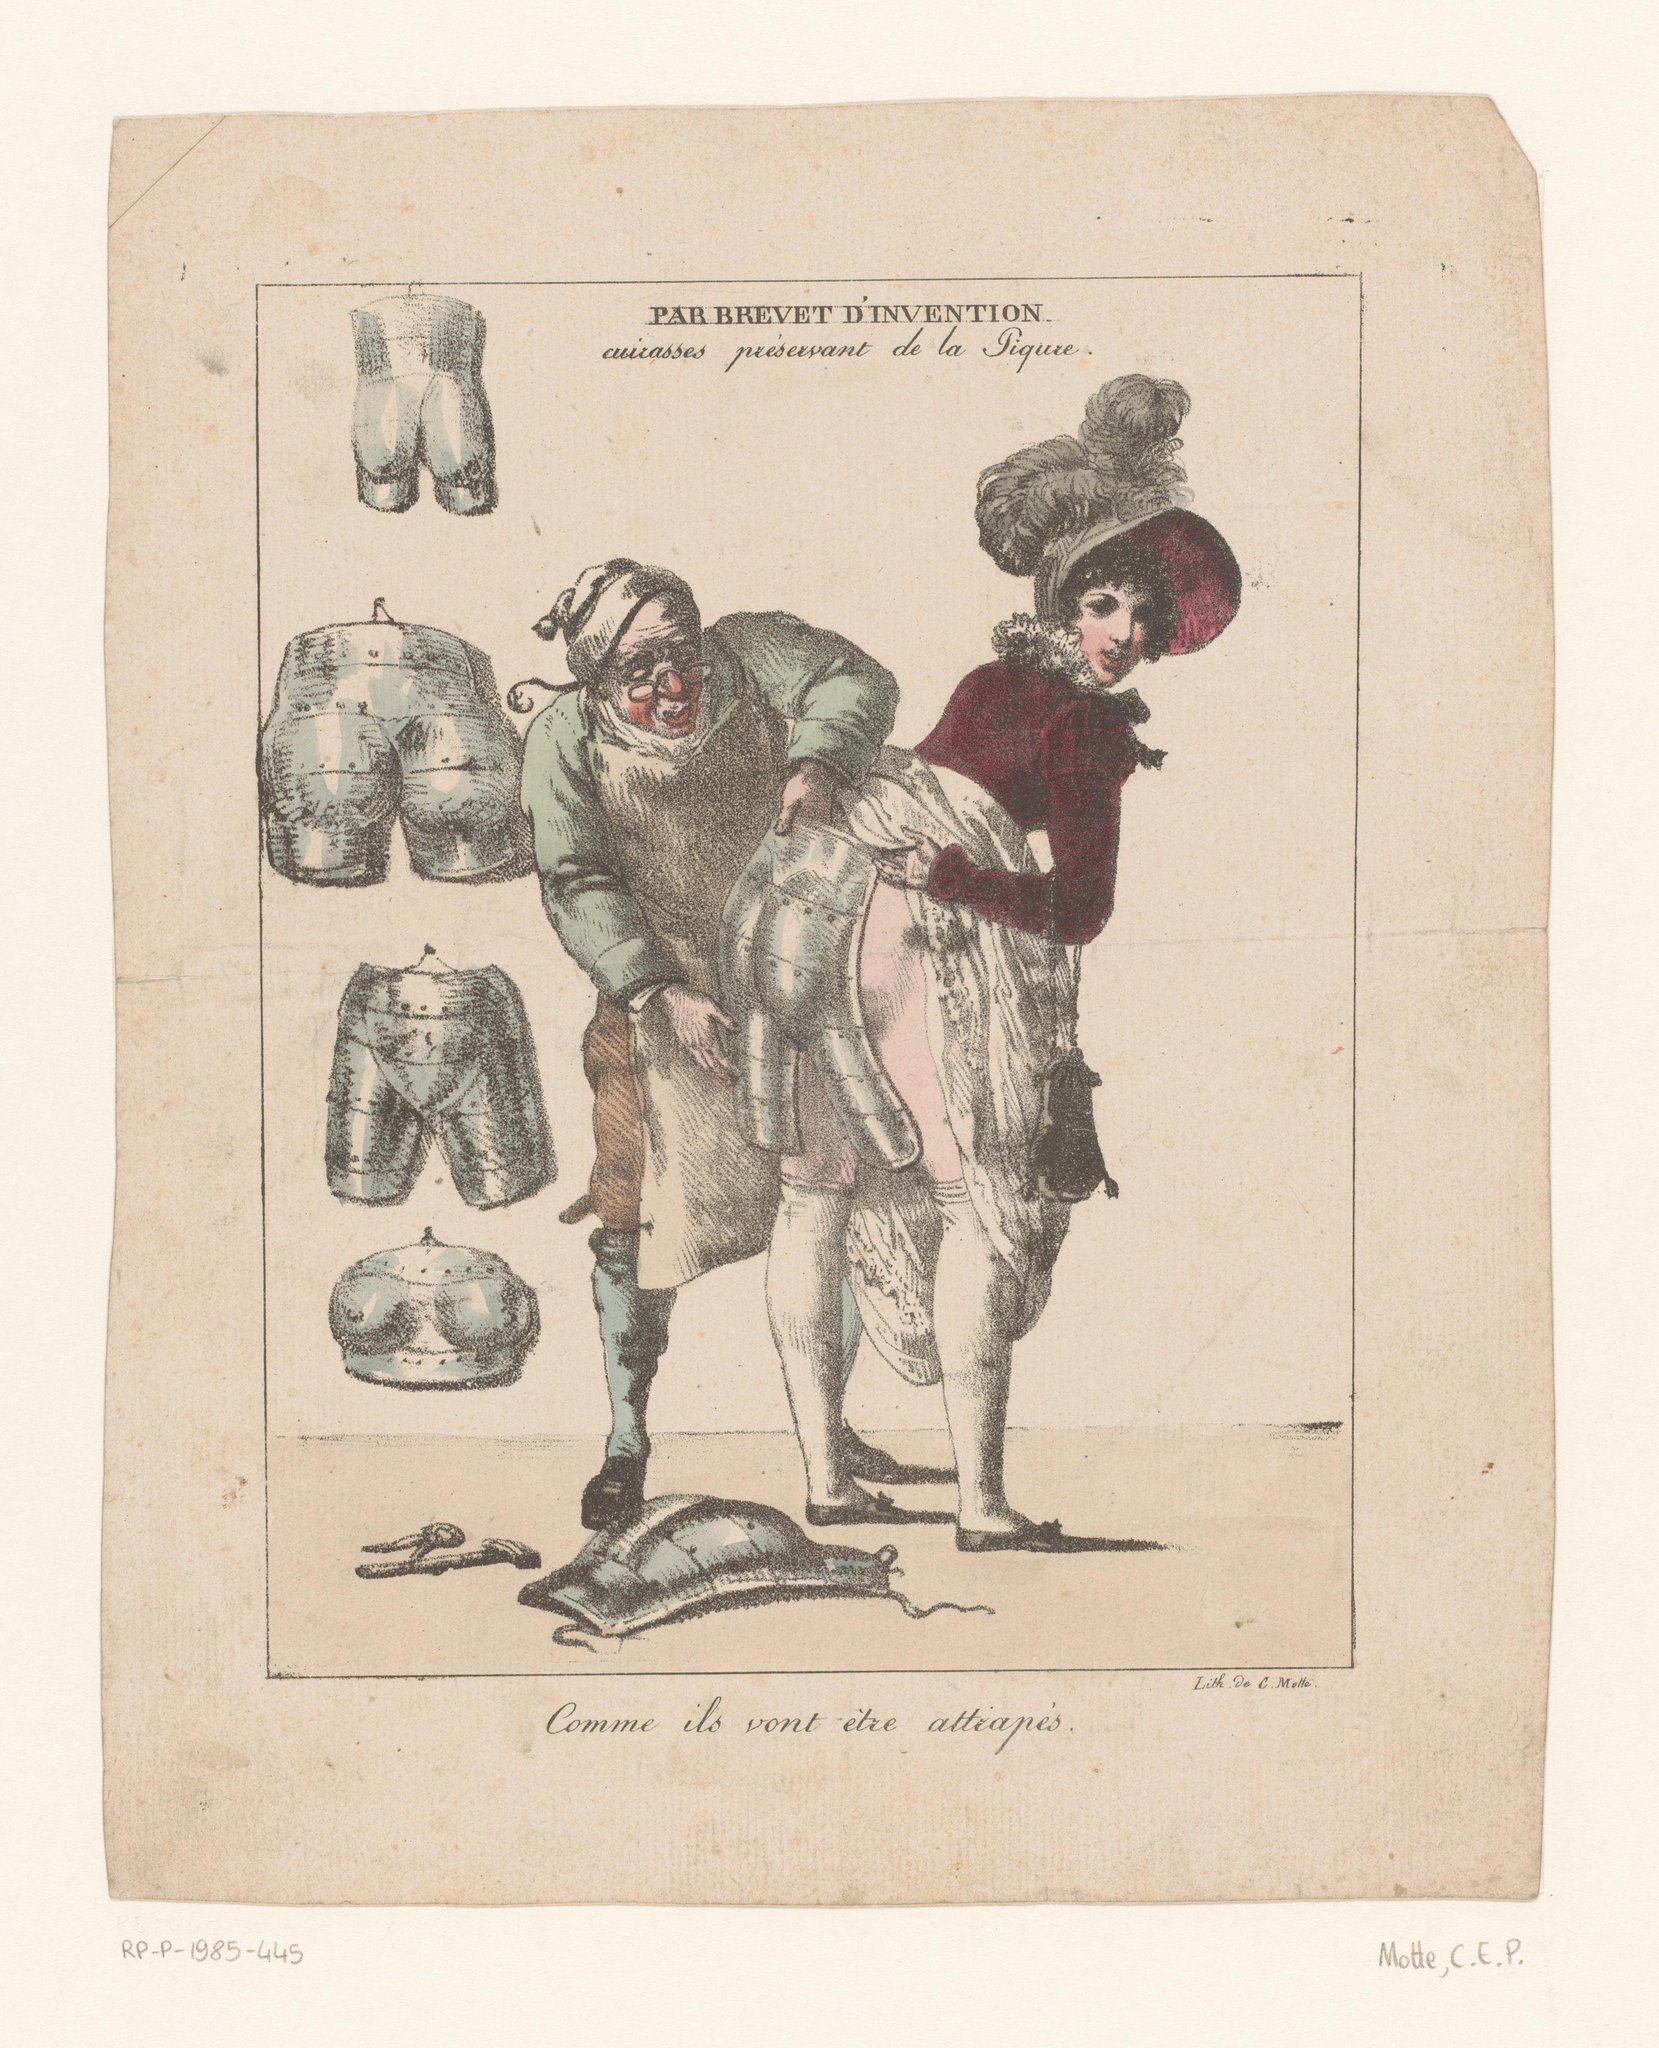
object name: cartoon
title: Par brevet d'invention, cuirasses préservant de la piqure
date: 1817-1837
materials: paper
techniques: hand coloring, lithograph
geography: paris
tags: fashion, clothing, adult woman, armour, tailor, dressmaker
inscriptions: collector's mark: Lugt 2760, collector's mark: Lugt 2228